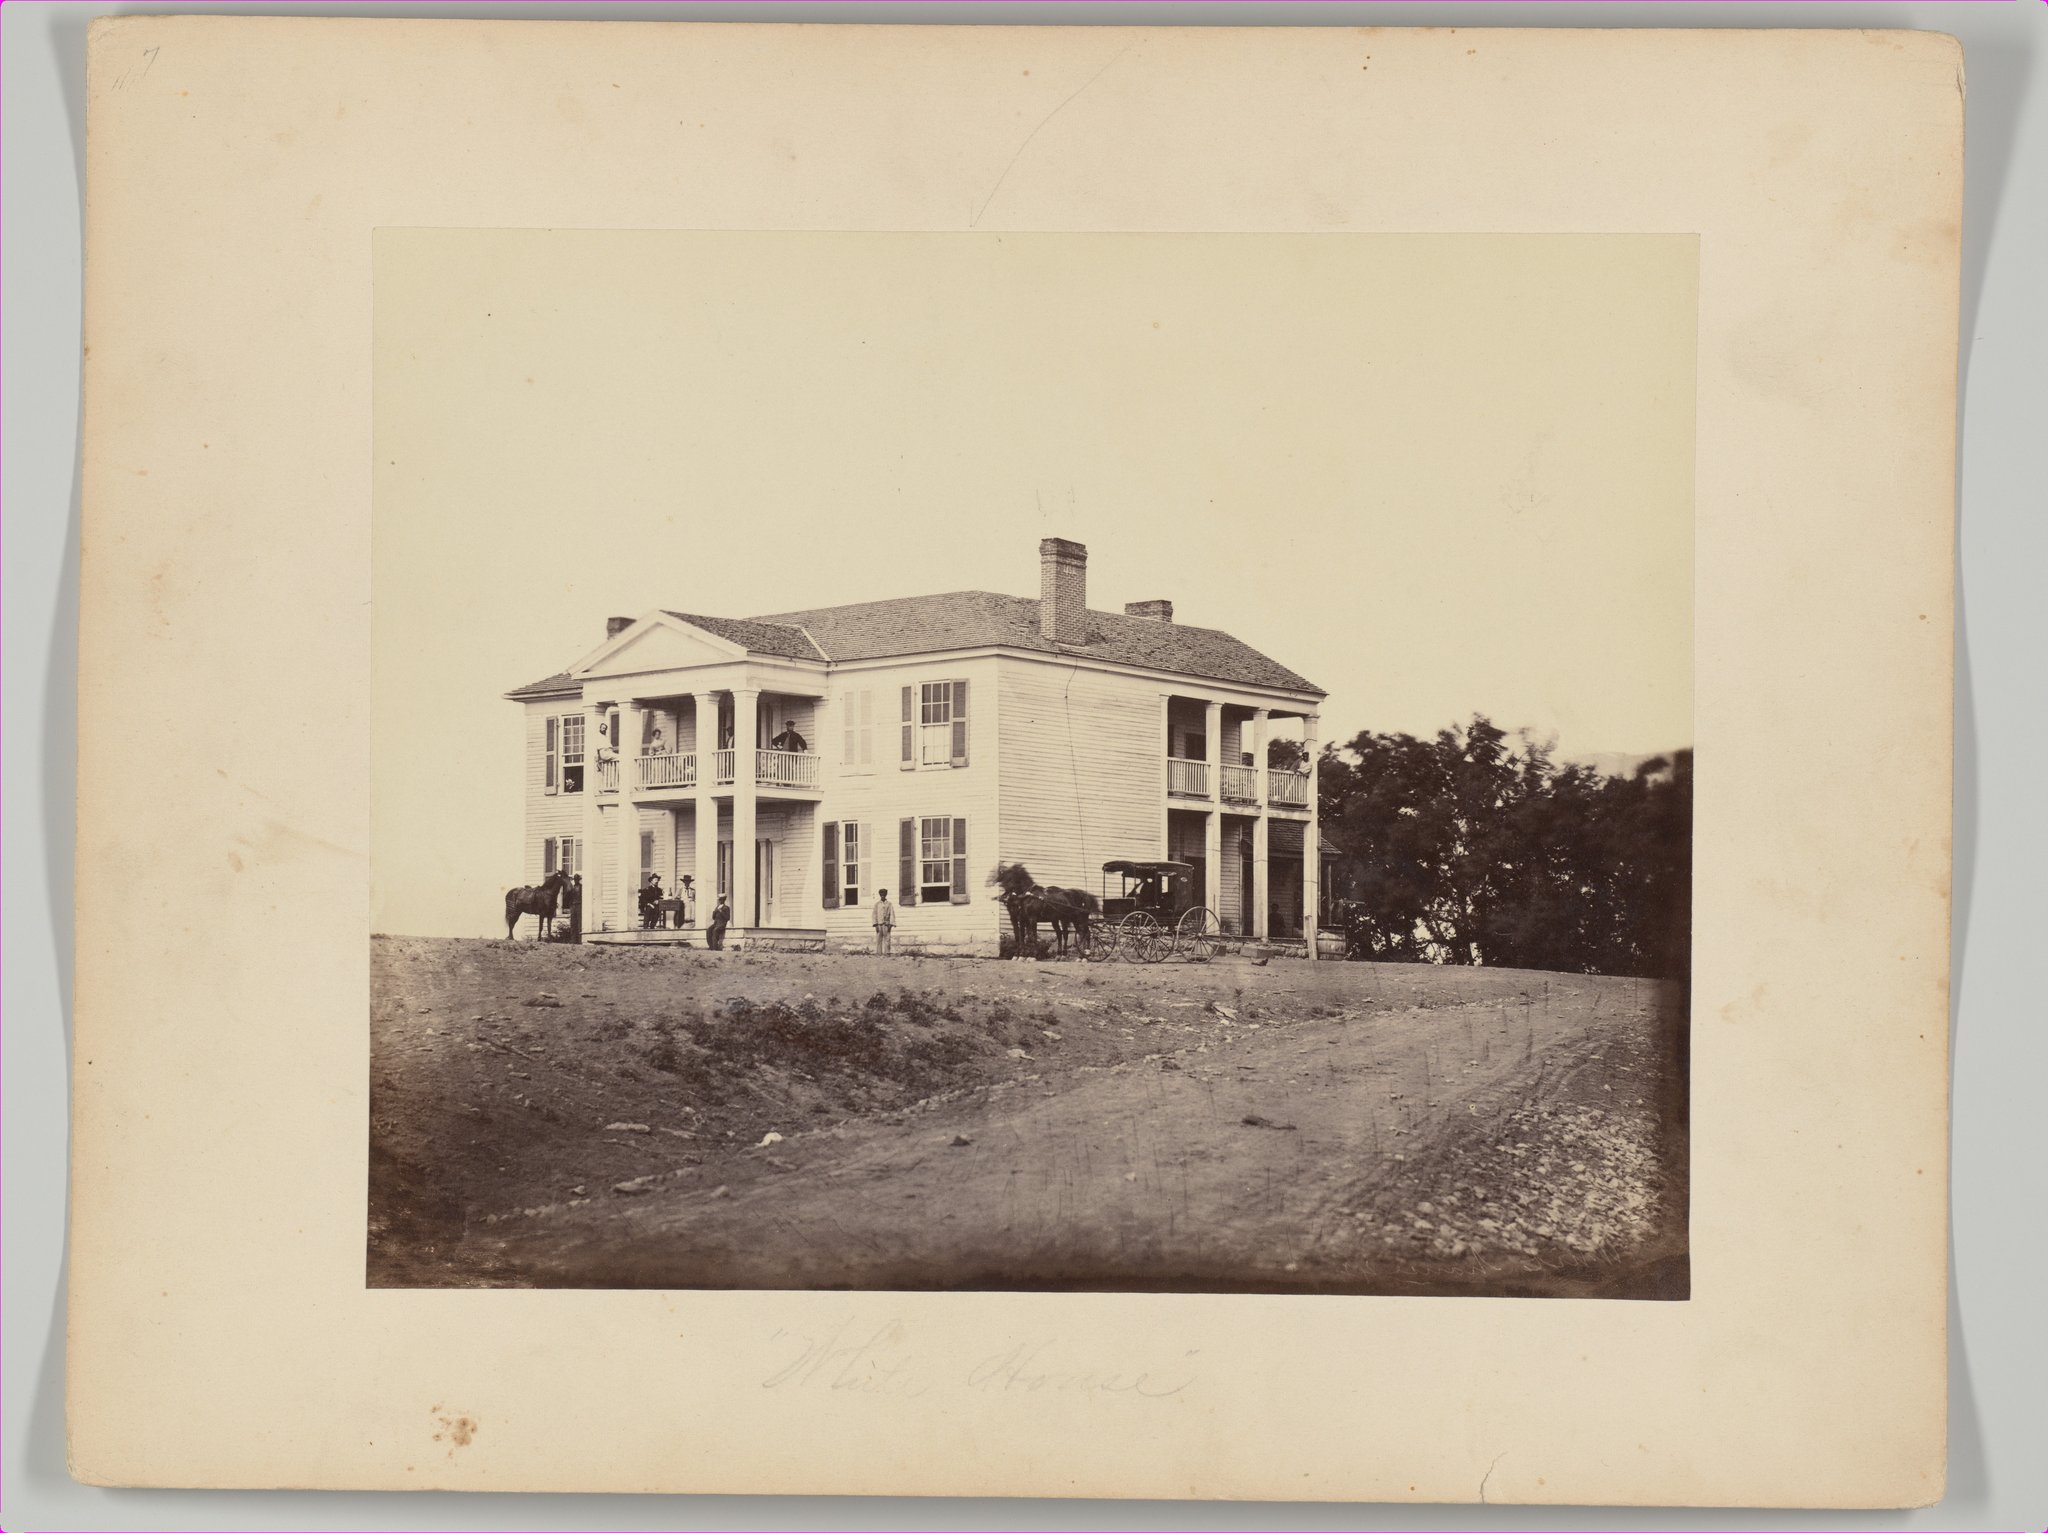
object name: photograph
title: White House, Camp Nelson, Kentucky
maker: g. w. foster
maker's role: artist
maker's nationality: american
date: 1863-1864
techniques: albumen silver print, glass negative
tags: houses,american civil war,horses,carriages